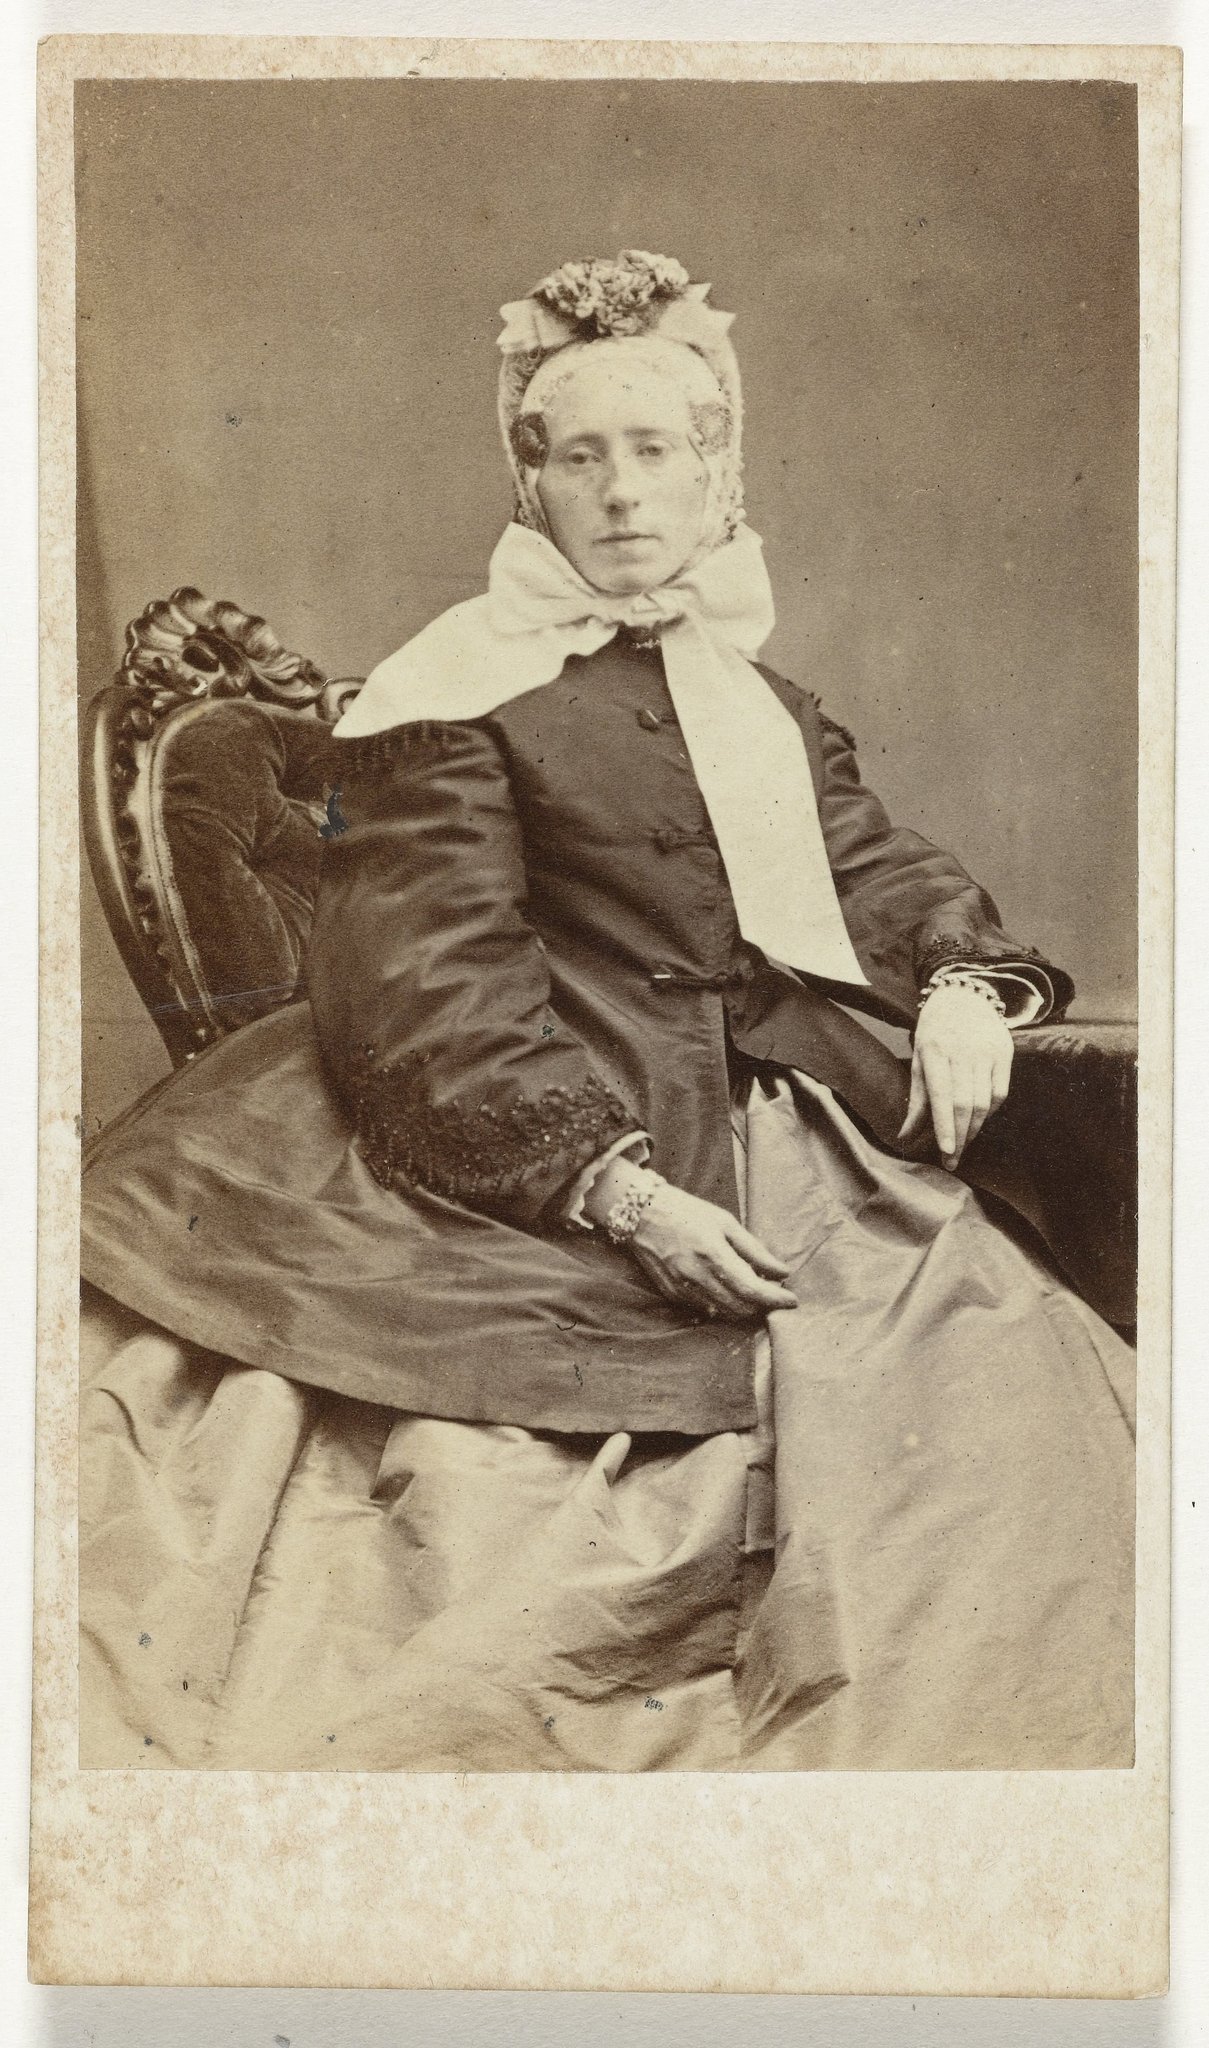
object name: carte de visite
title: Portret van een vrouw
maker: hermanus philippus jacobus schuiten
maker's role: fotograaf, lijstenmaker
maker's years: 1820-1869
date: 1864-1868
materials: cardboard, paper, photographic support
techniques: albumen print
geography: amsterdam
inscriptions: address: ‘Atelier de Photographie/H.PH.J. Schuiten/Amsterdam’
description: Vrouw in een donker jak en een licht rok, zittend naast een tafel. Zij draagt een hoofddeksel met een grote strik onder haar kin.